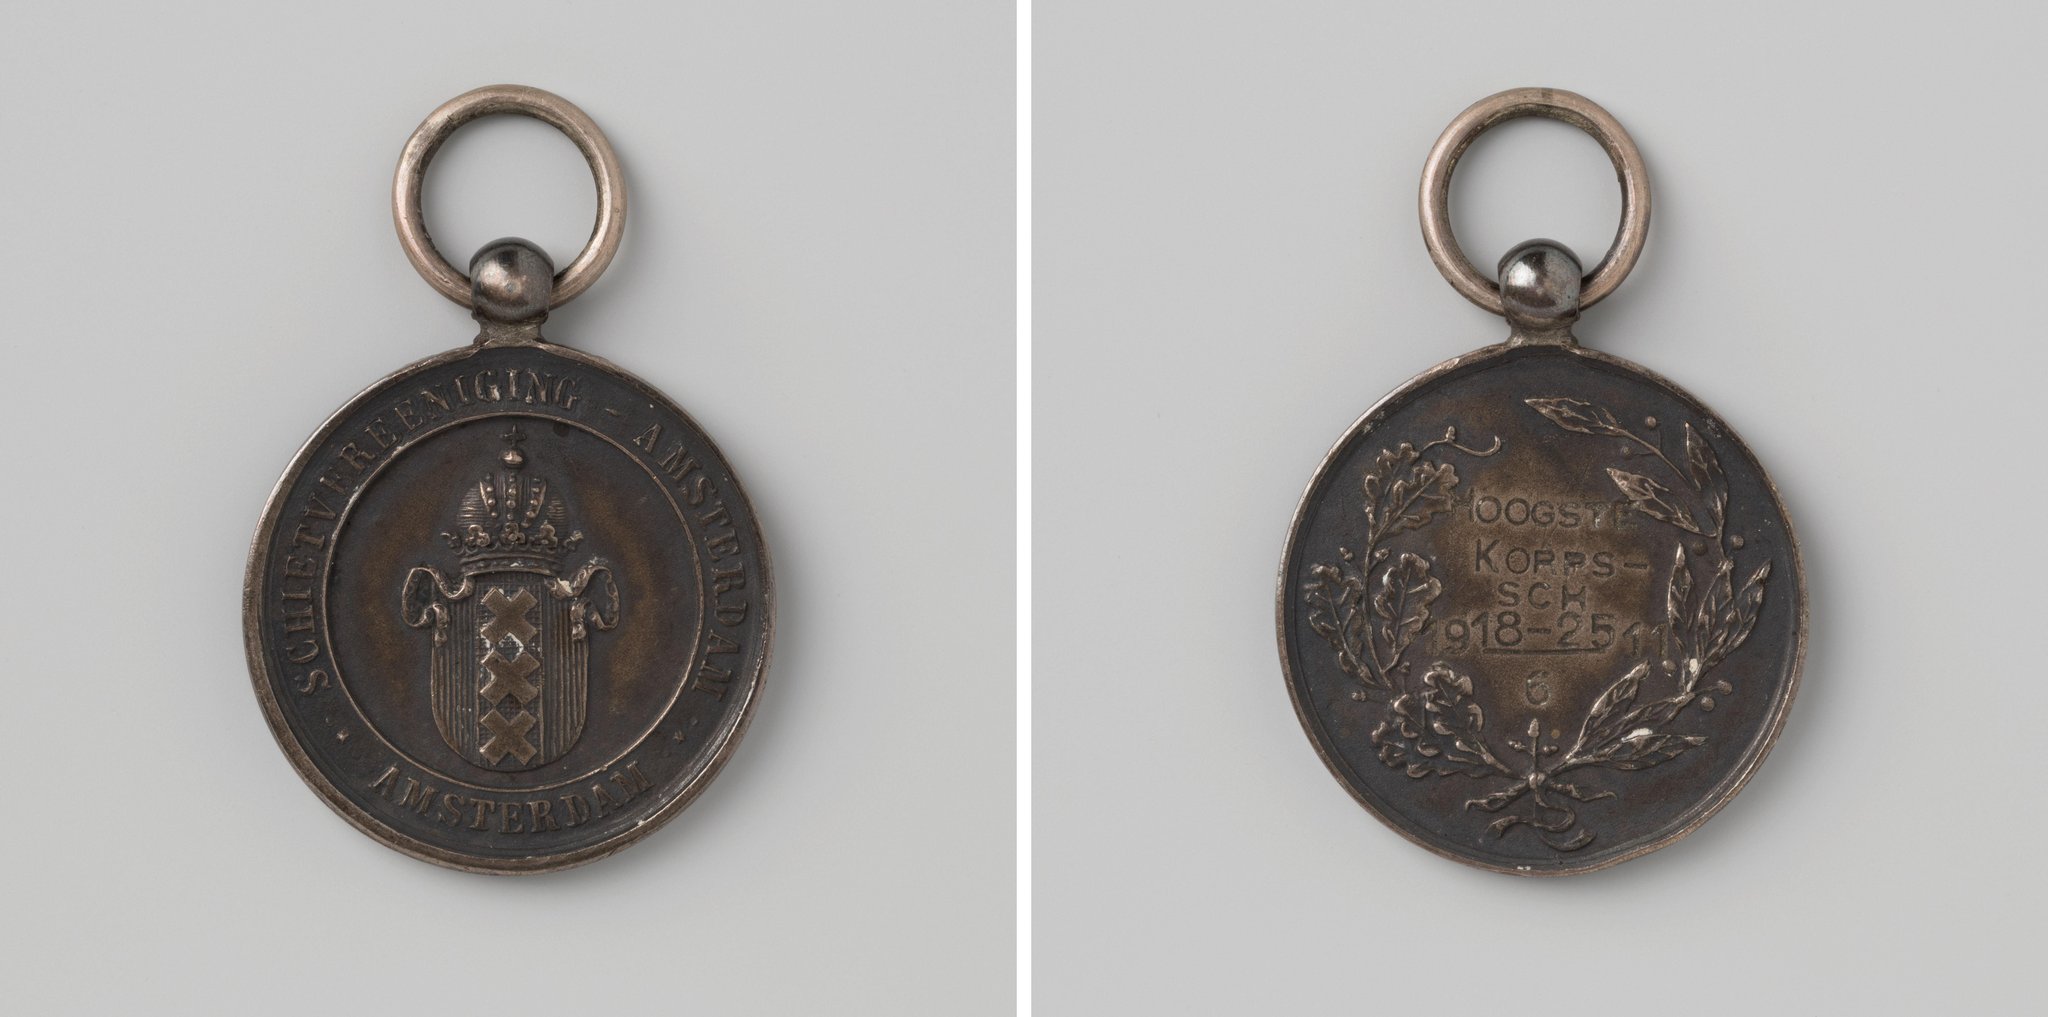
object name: medal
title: Prijspenning van de Schietvereeniging Amsterdam, uitgereikt 1911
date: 1880-1911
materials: silver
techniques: striking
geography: amsterdam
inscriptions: circumscription: ‘SCHIETVEREENIGING AMSTERDAM / AMSTERDAM’, inscription: ‘HOOGSTE / KORPS- / SCH / 19 18-25/6 11’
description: Zilveren penning met bal en draagring, op de voorzijde een gekroond wapenschild Amsterdam, met omschrift, op de keerzijde een inscriptieruimte tussen een samengestrikte eiken- en lauwertak.